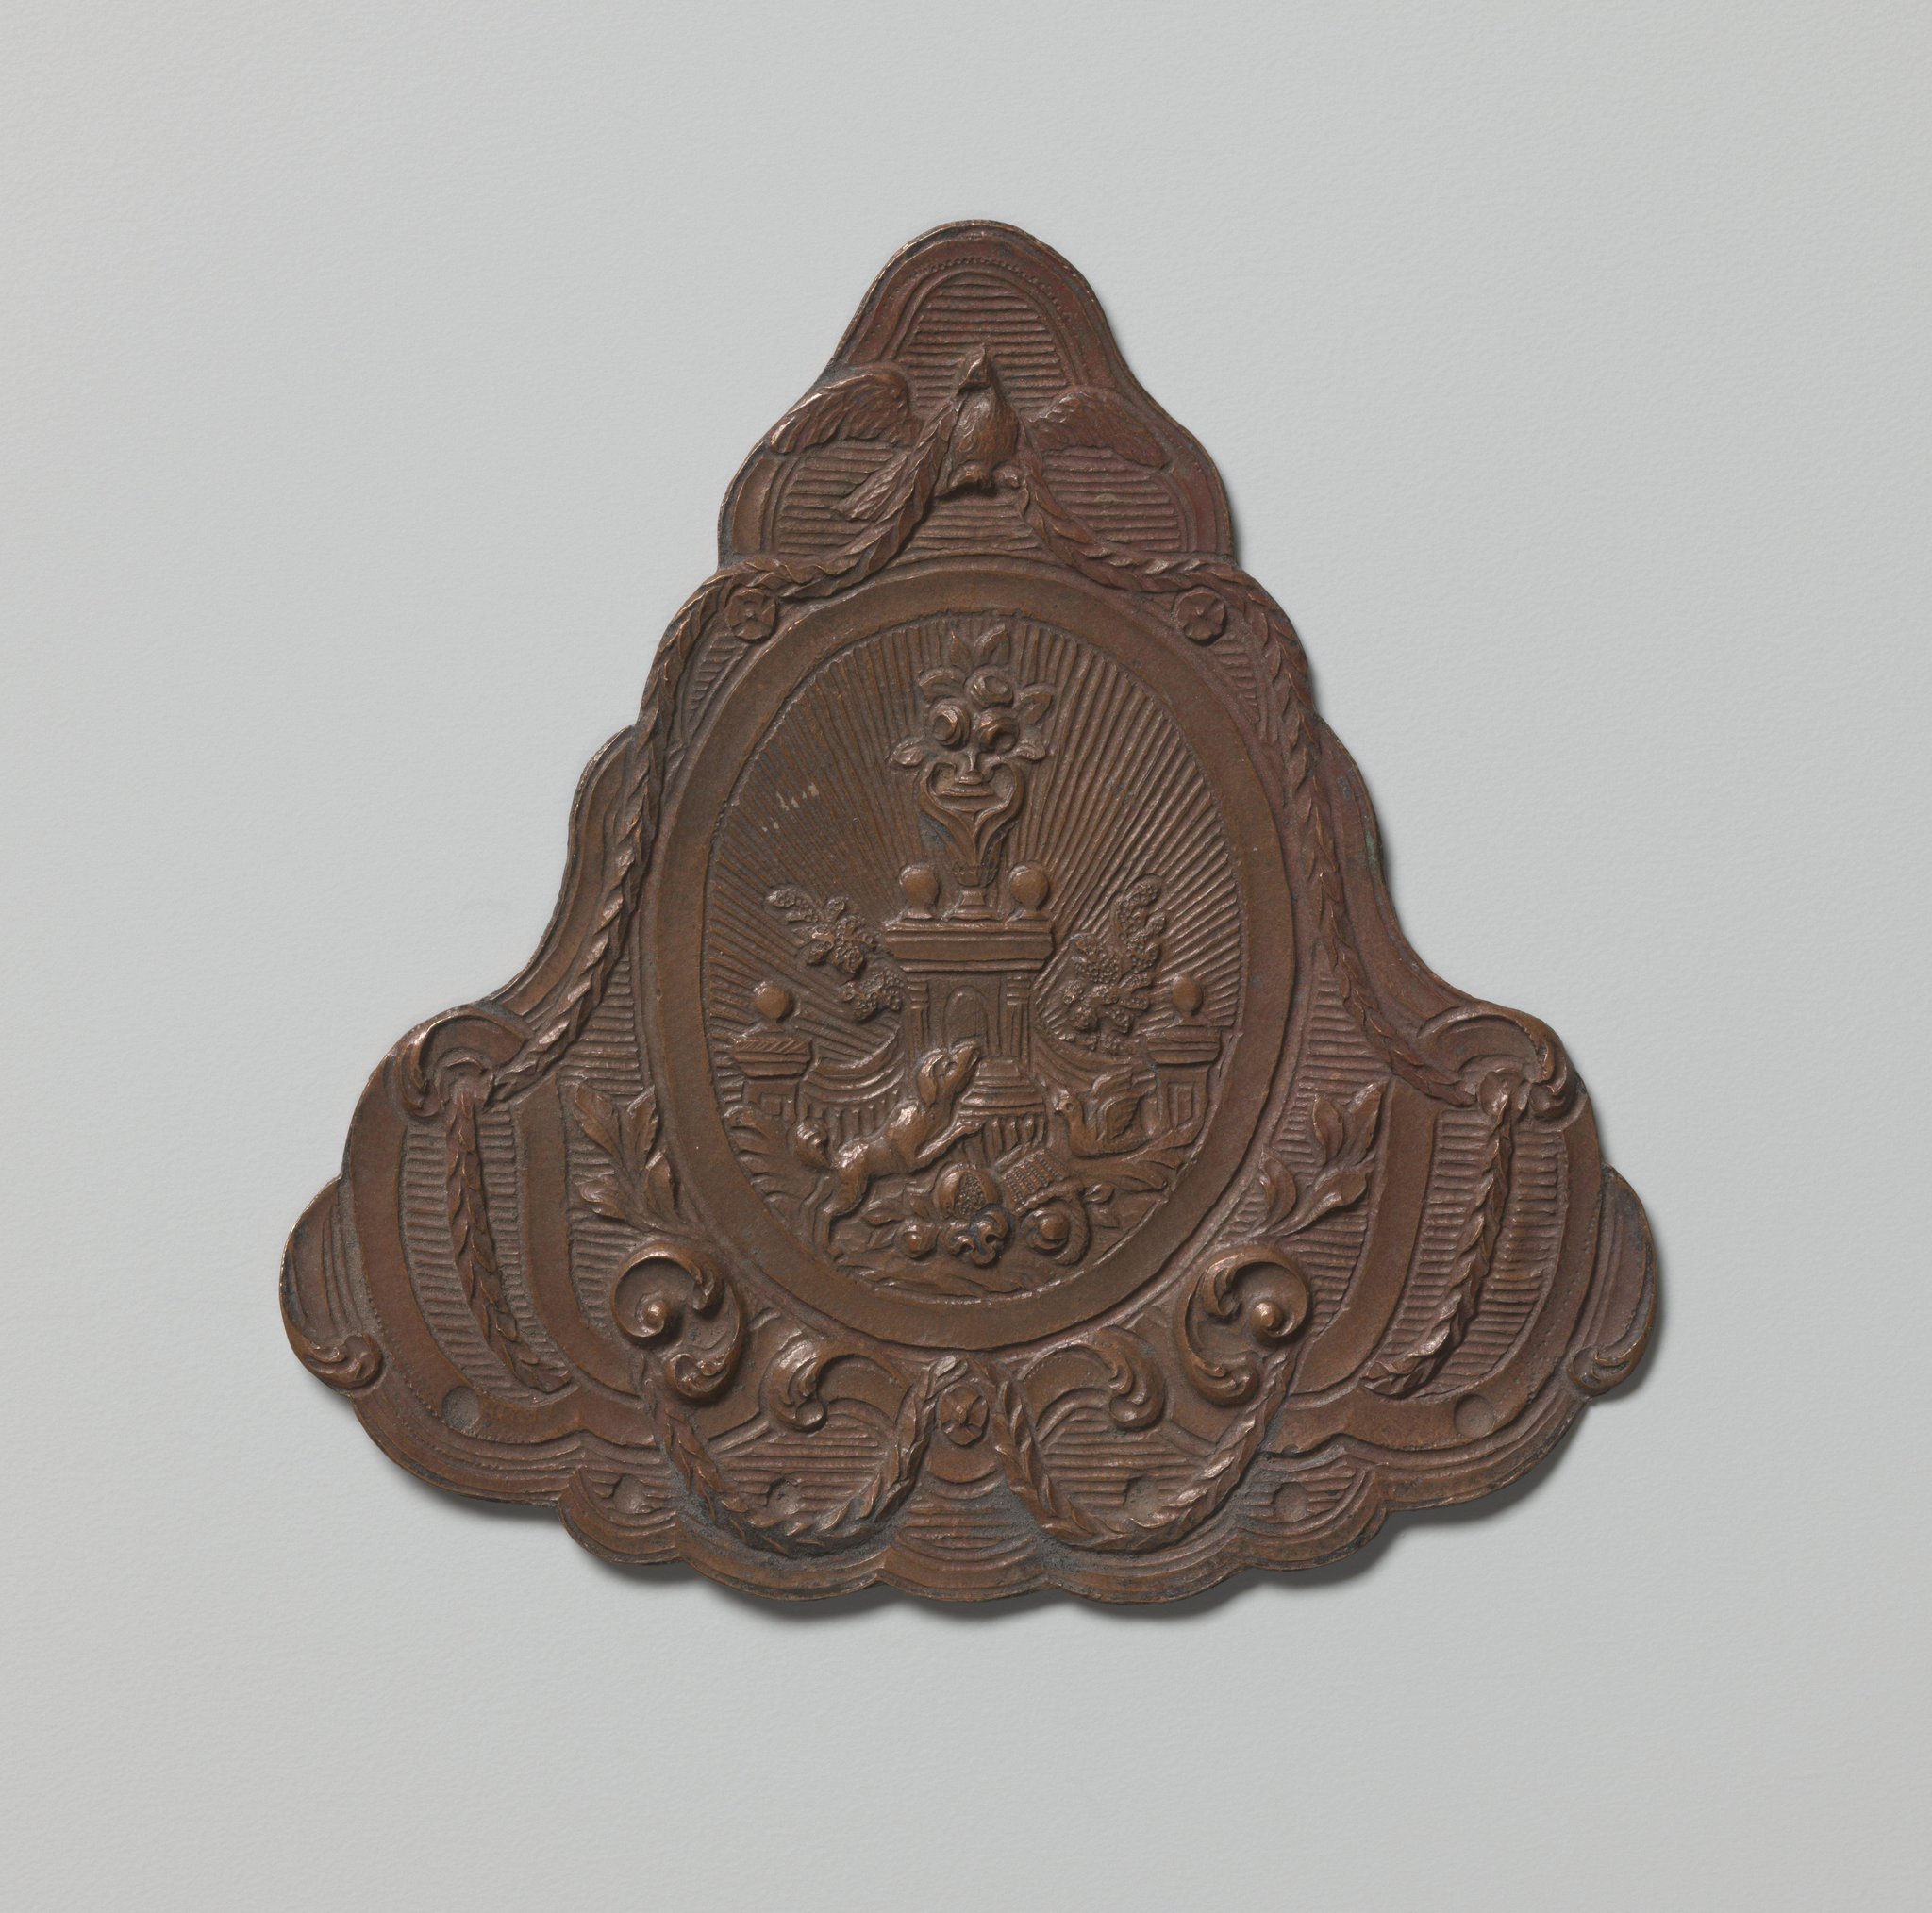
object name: chatelaine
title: Model voor een haakplaat van een chatelaine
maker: Anonymous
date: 1775-1800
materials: copper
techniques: repoussé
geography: amsterdam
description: Het uit plaat gemaakte driehoekige model voor een gietvorm heeft een gedreven versiering met een medaillon, waaromheen tegen een gearceerde achtergrond een doorlopende over krullen en ander ornament gedrapeerde slinger, welke wordt opgehouden door een vogel. In het medaillon een vaas met bloemen op een balustrade waarvoor een hond en een vogel.